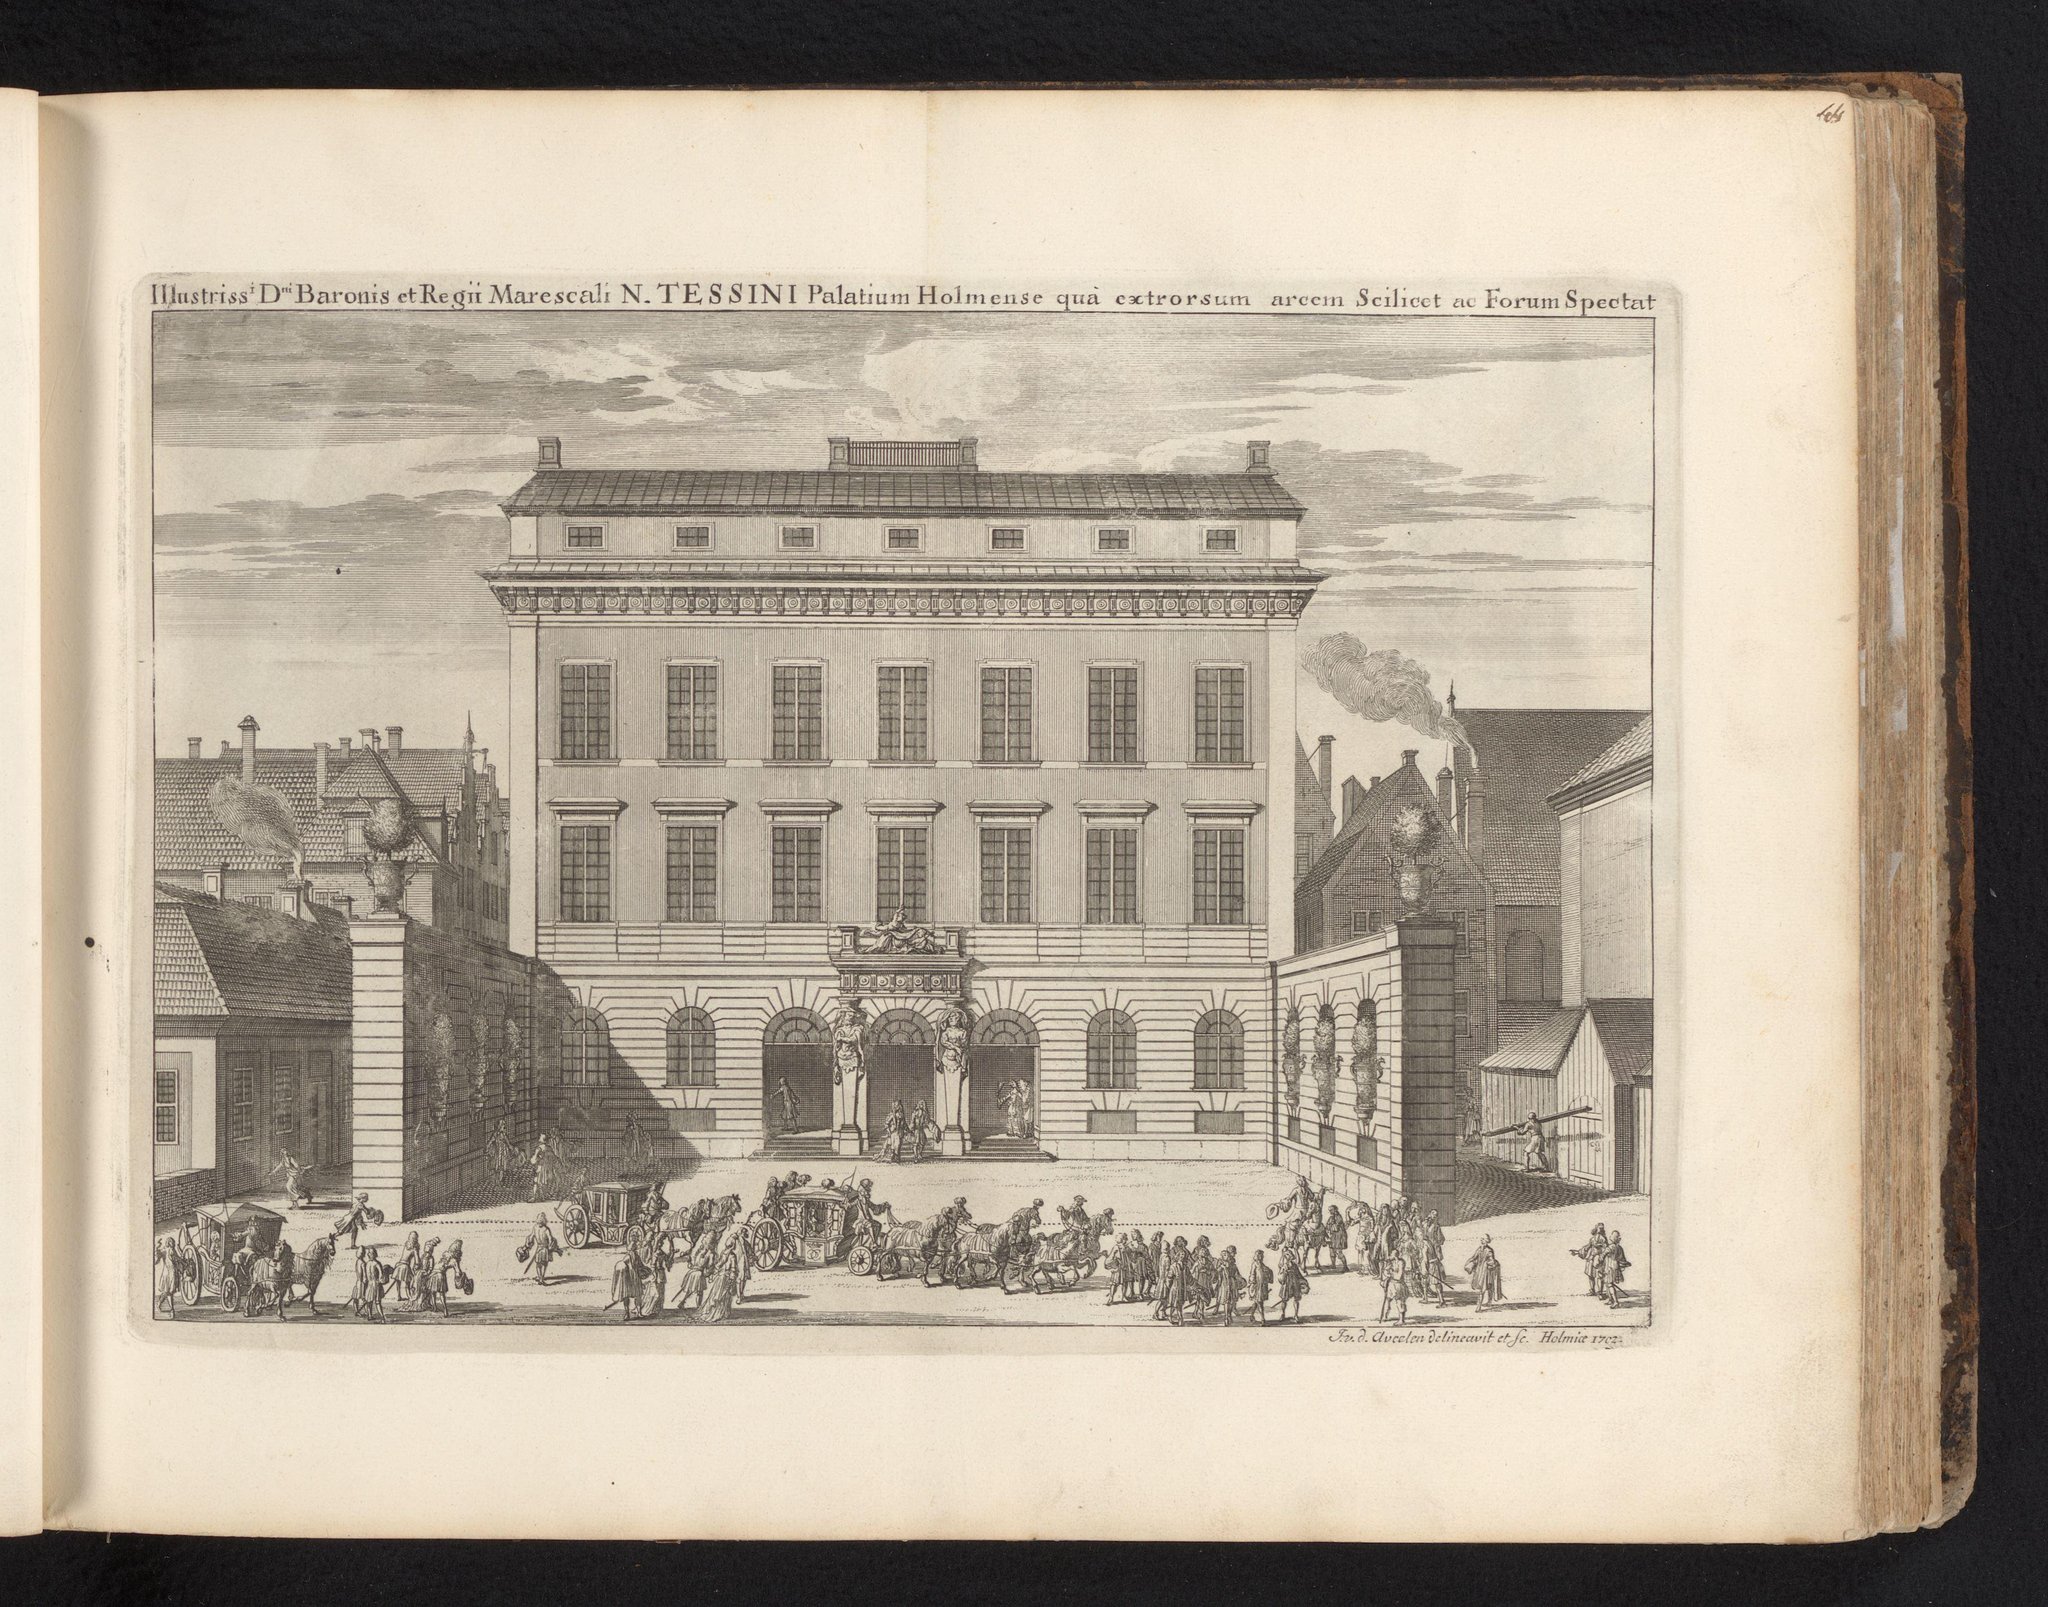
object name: print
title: Illustriss:i D:ni Baronis et Regii Marescali N: Tessini Palatium Holmense qua extrorsum arcem Scilicet ac Forum Spectat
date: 1702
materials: paper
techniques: etching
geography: stockholm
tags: palace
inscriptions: date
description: Kungliga Biblioteket, 'Suecia': http://www.kb.se/samlingarna/Kartor-bilder/Suecia-antiqua/ (geraadpleegd november 2016).